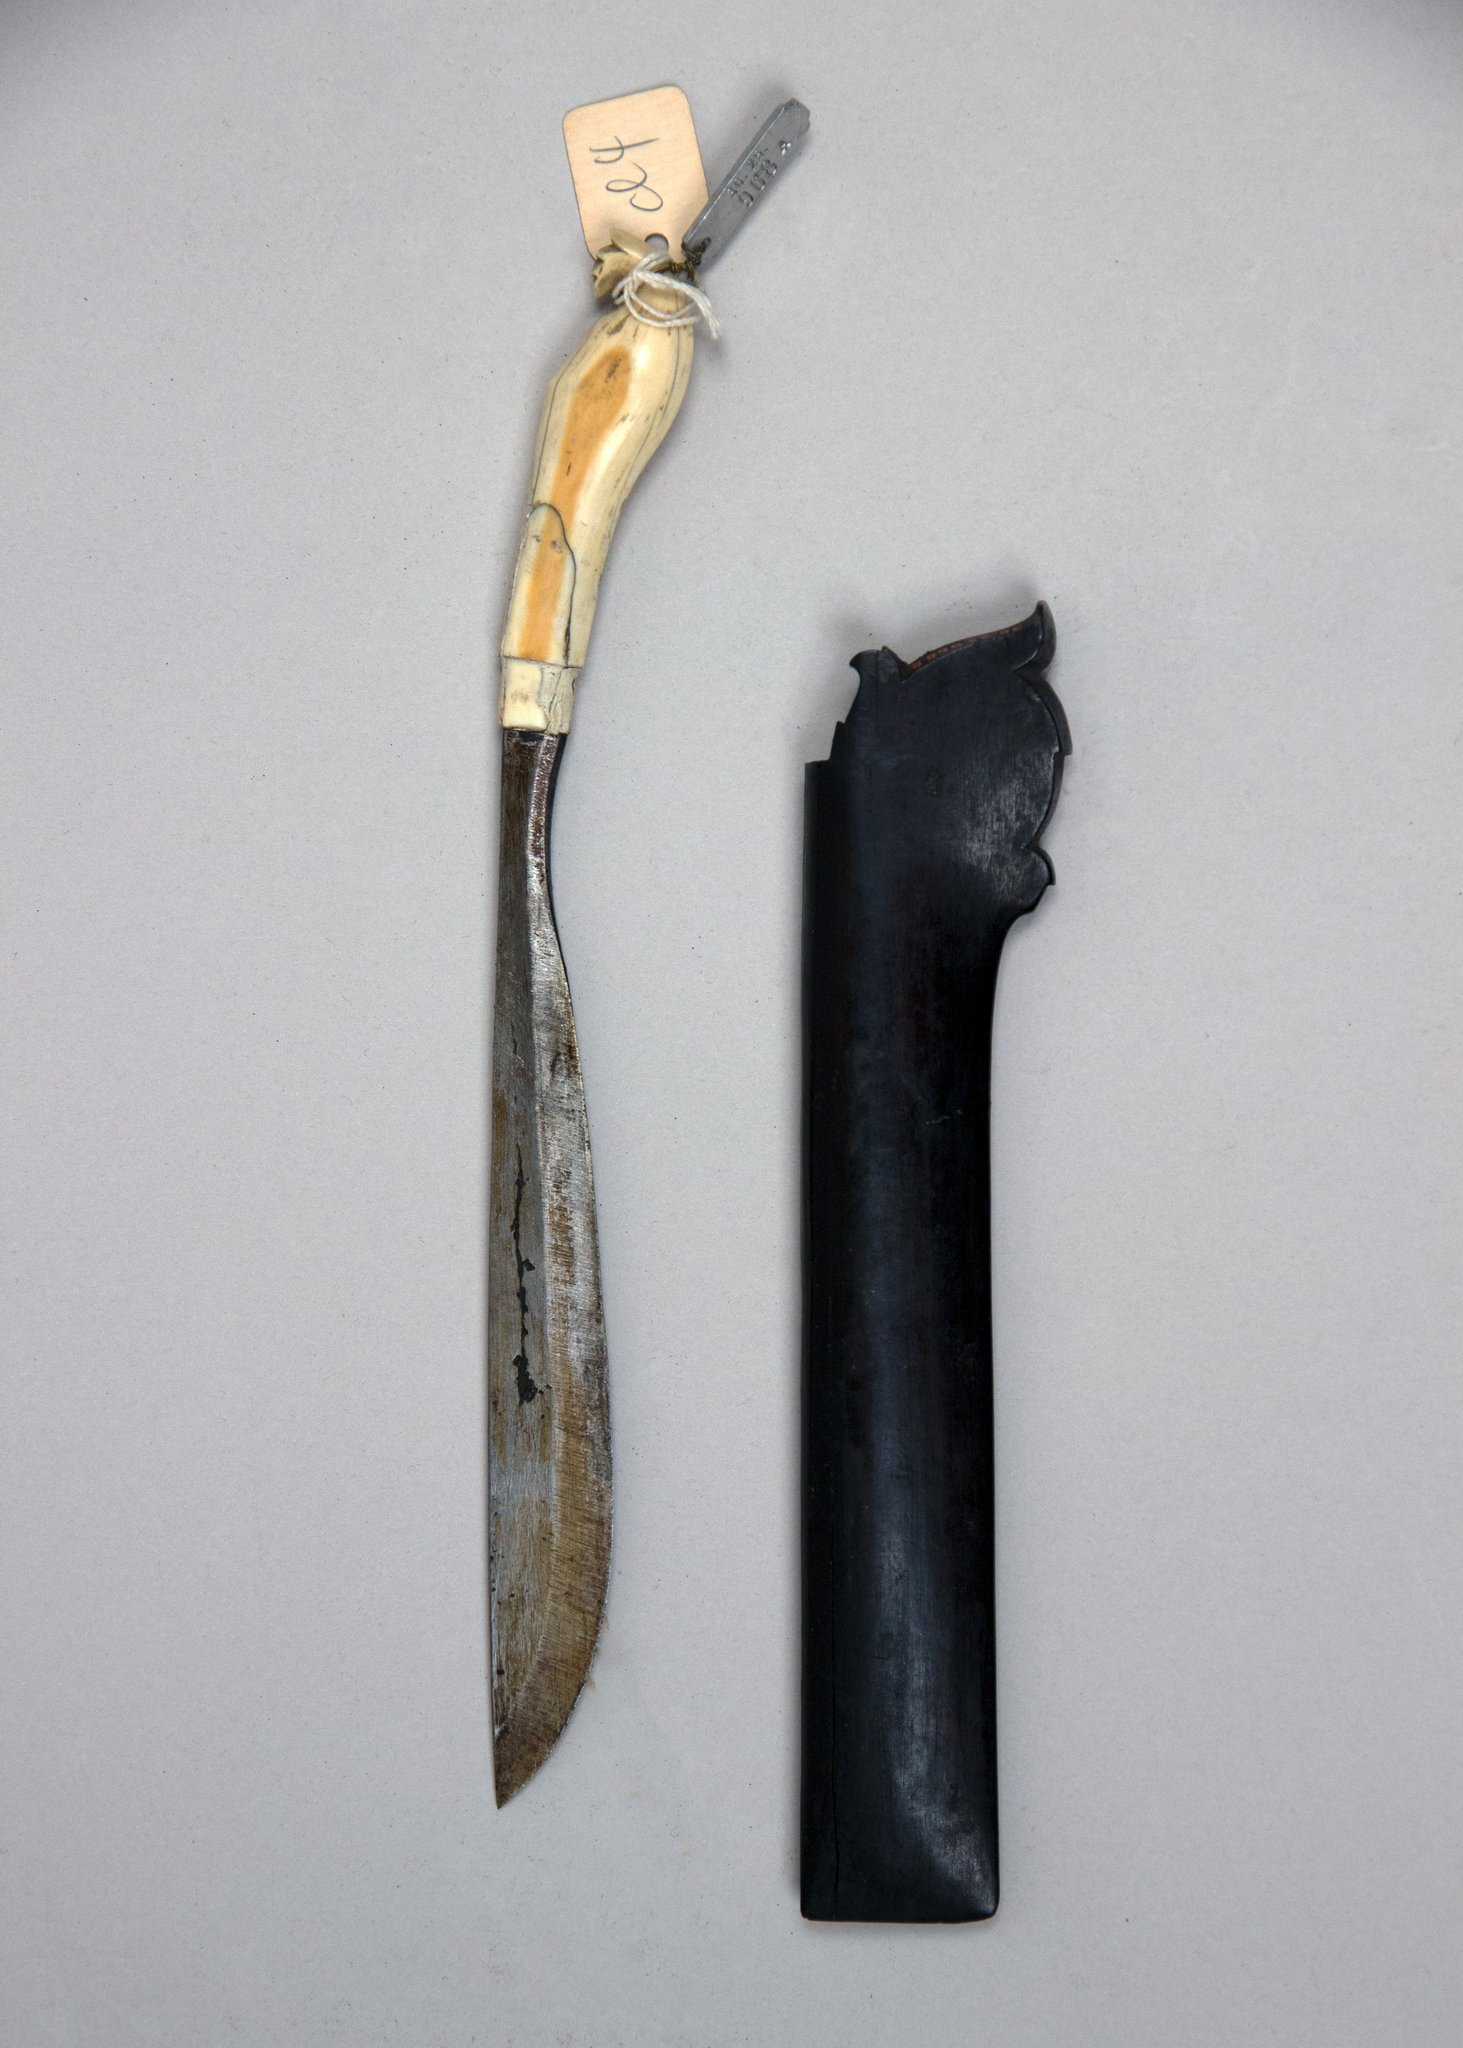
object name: knife golok with sheath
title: Knife (Golok) with Sheath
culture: sumatran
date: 1701-1900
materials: ivory, steel, wood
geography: indonesia